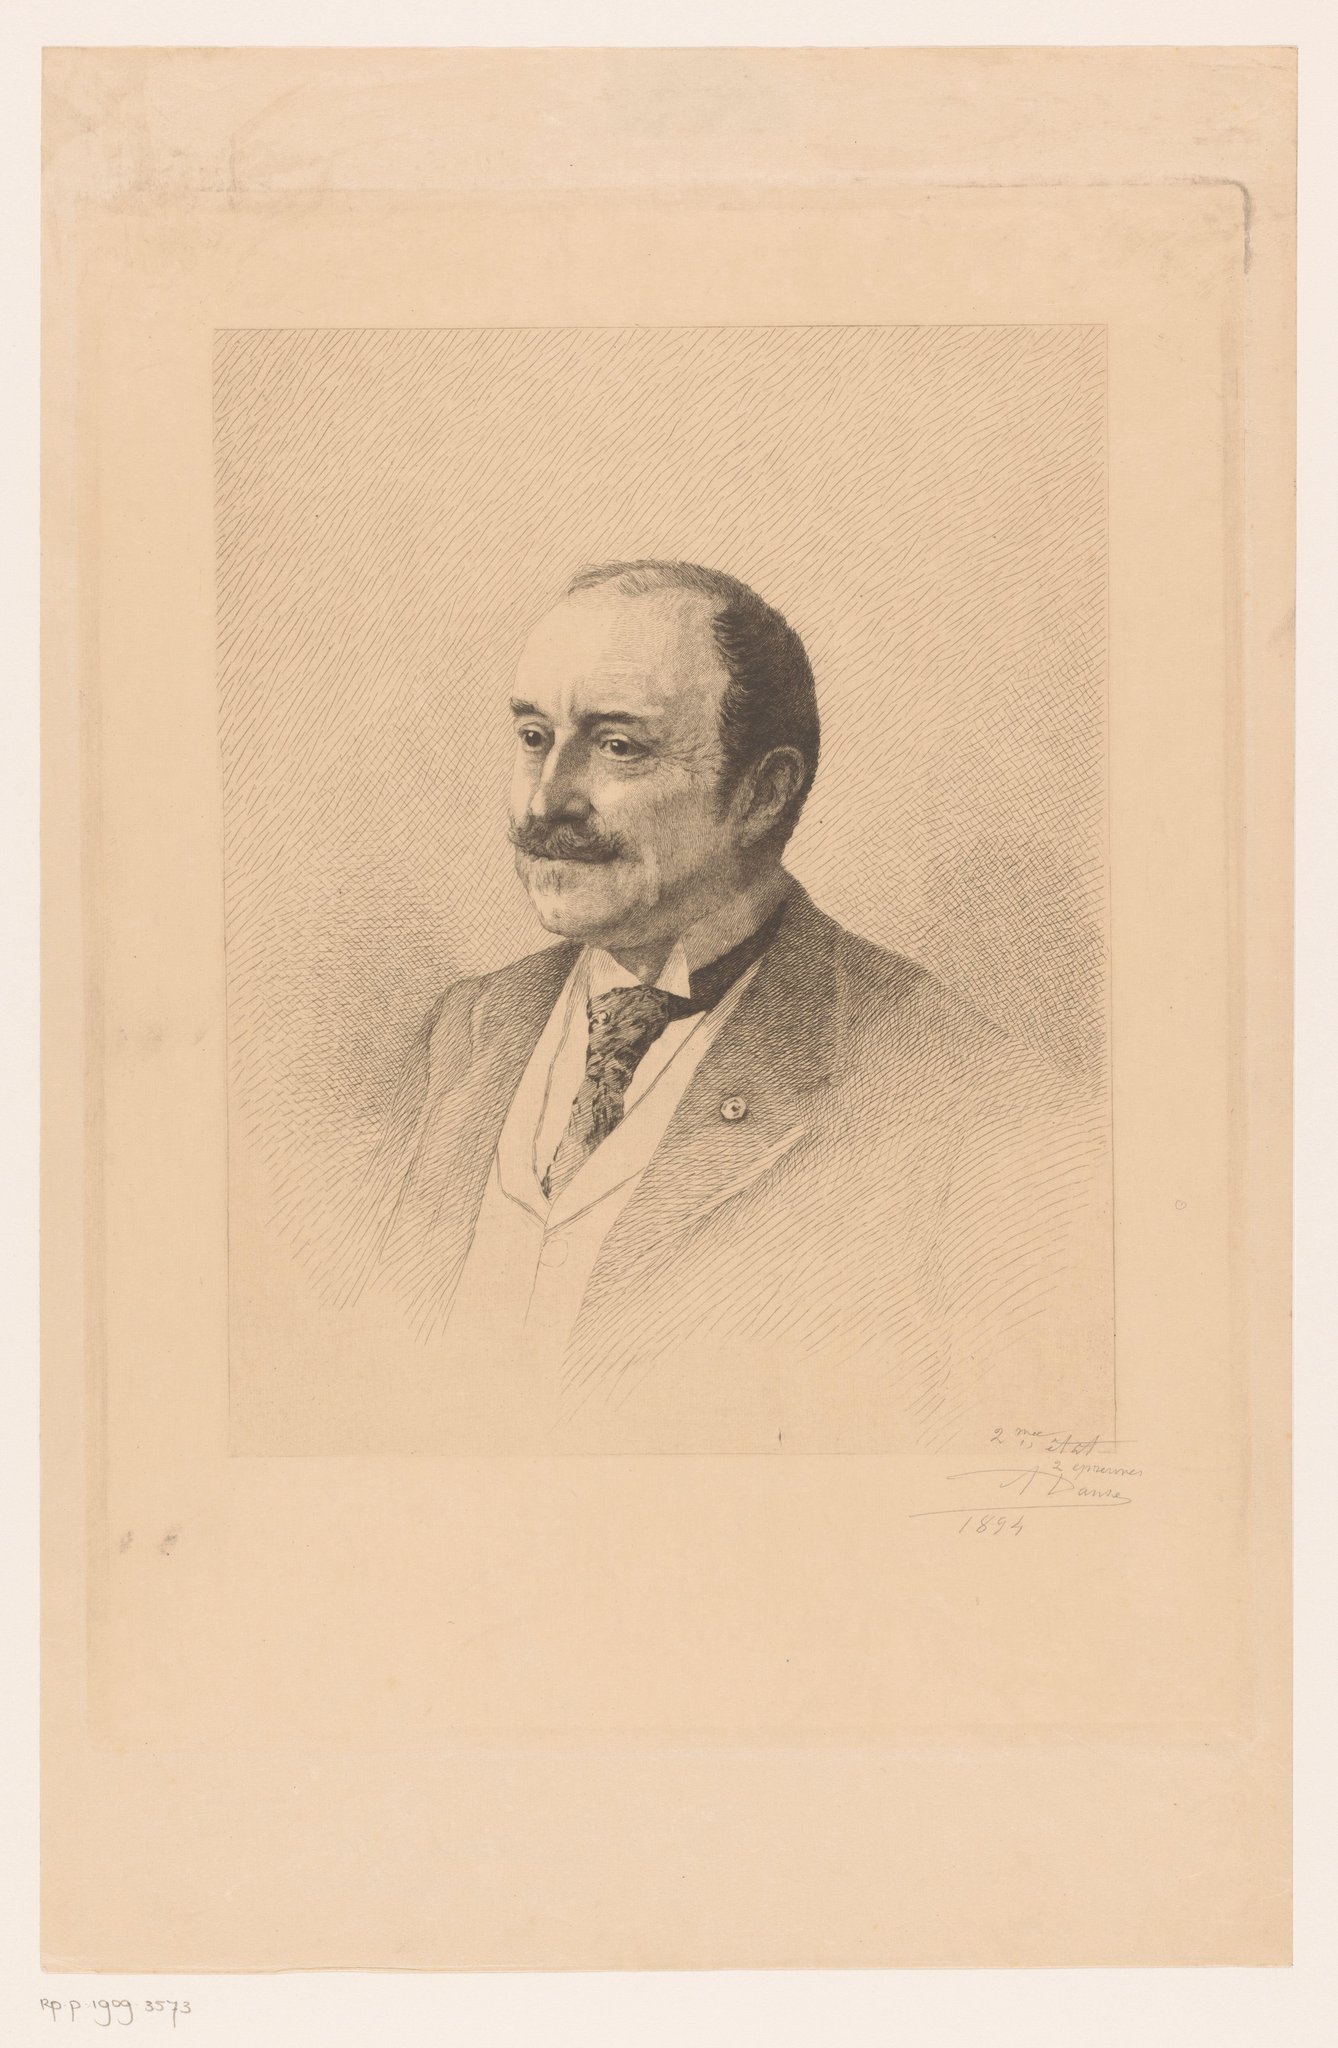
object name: print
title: Portret van een onbekende man, monsieur Laporte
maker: auguste danse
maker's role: print maker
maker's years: 1829-1929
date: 1894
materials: paper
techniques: etching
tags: anonymous historical person portrayed alone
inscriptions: annotation: ‘2me état 2 epreuves’, collector's mark: Lugt 2228